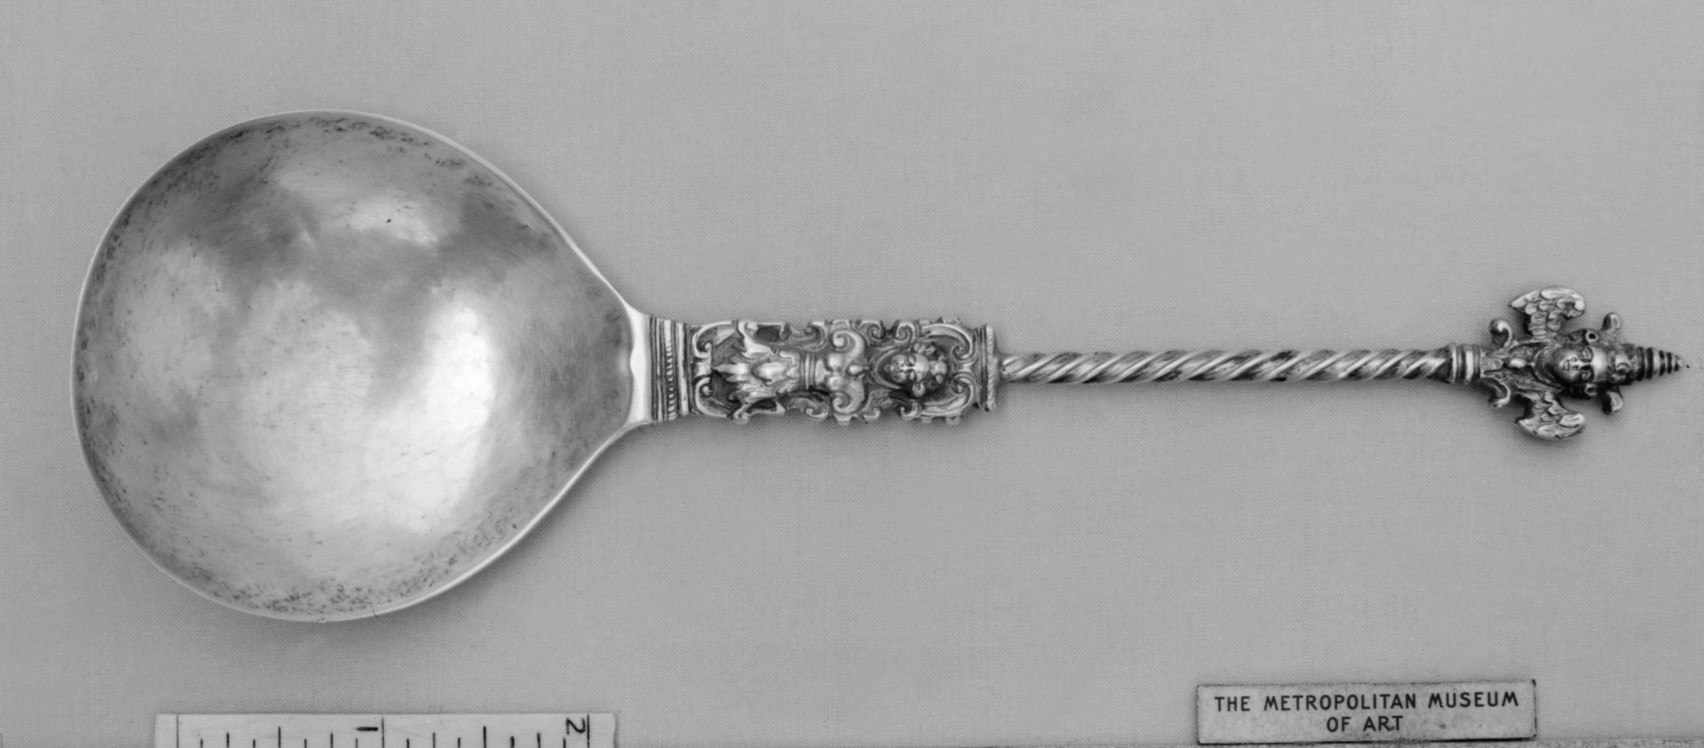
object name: spoon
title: Figure-top spoon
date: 1851-1900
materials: silver